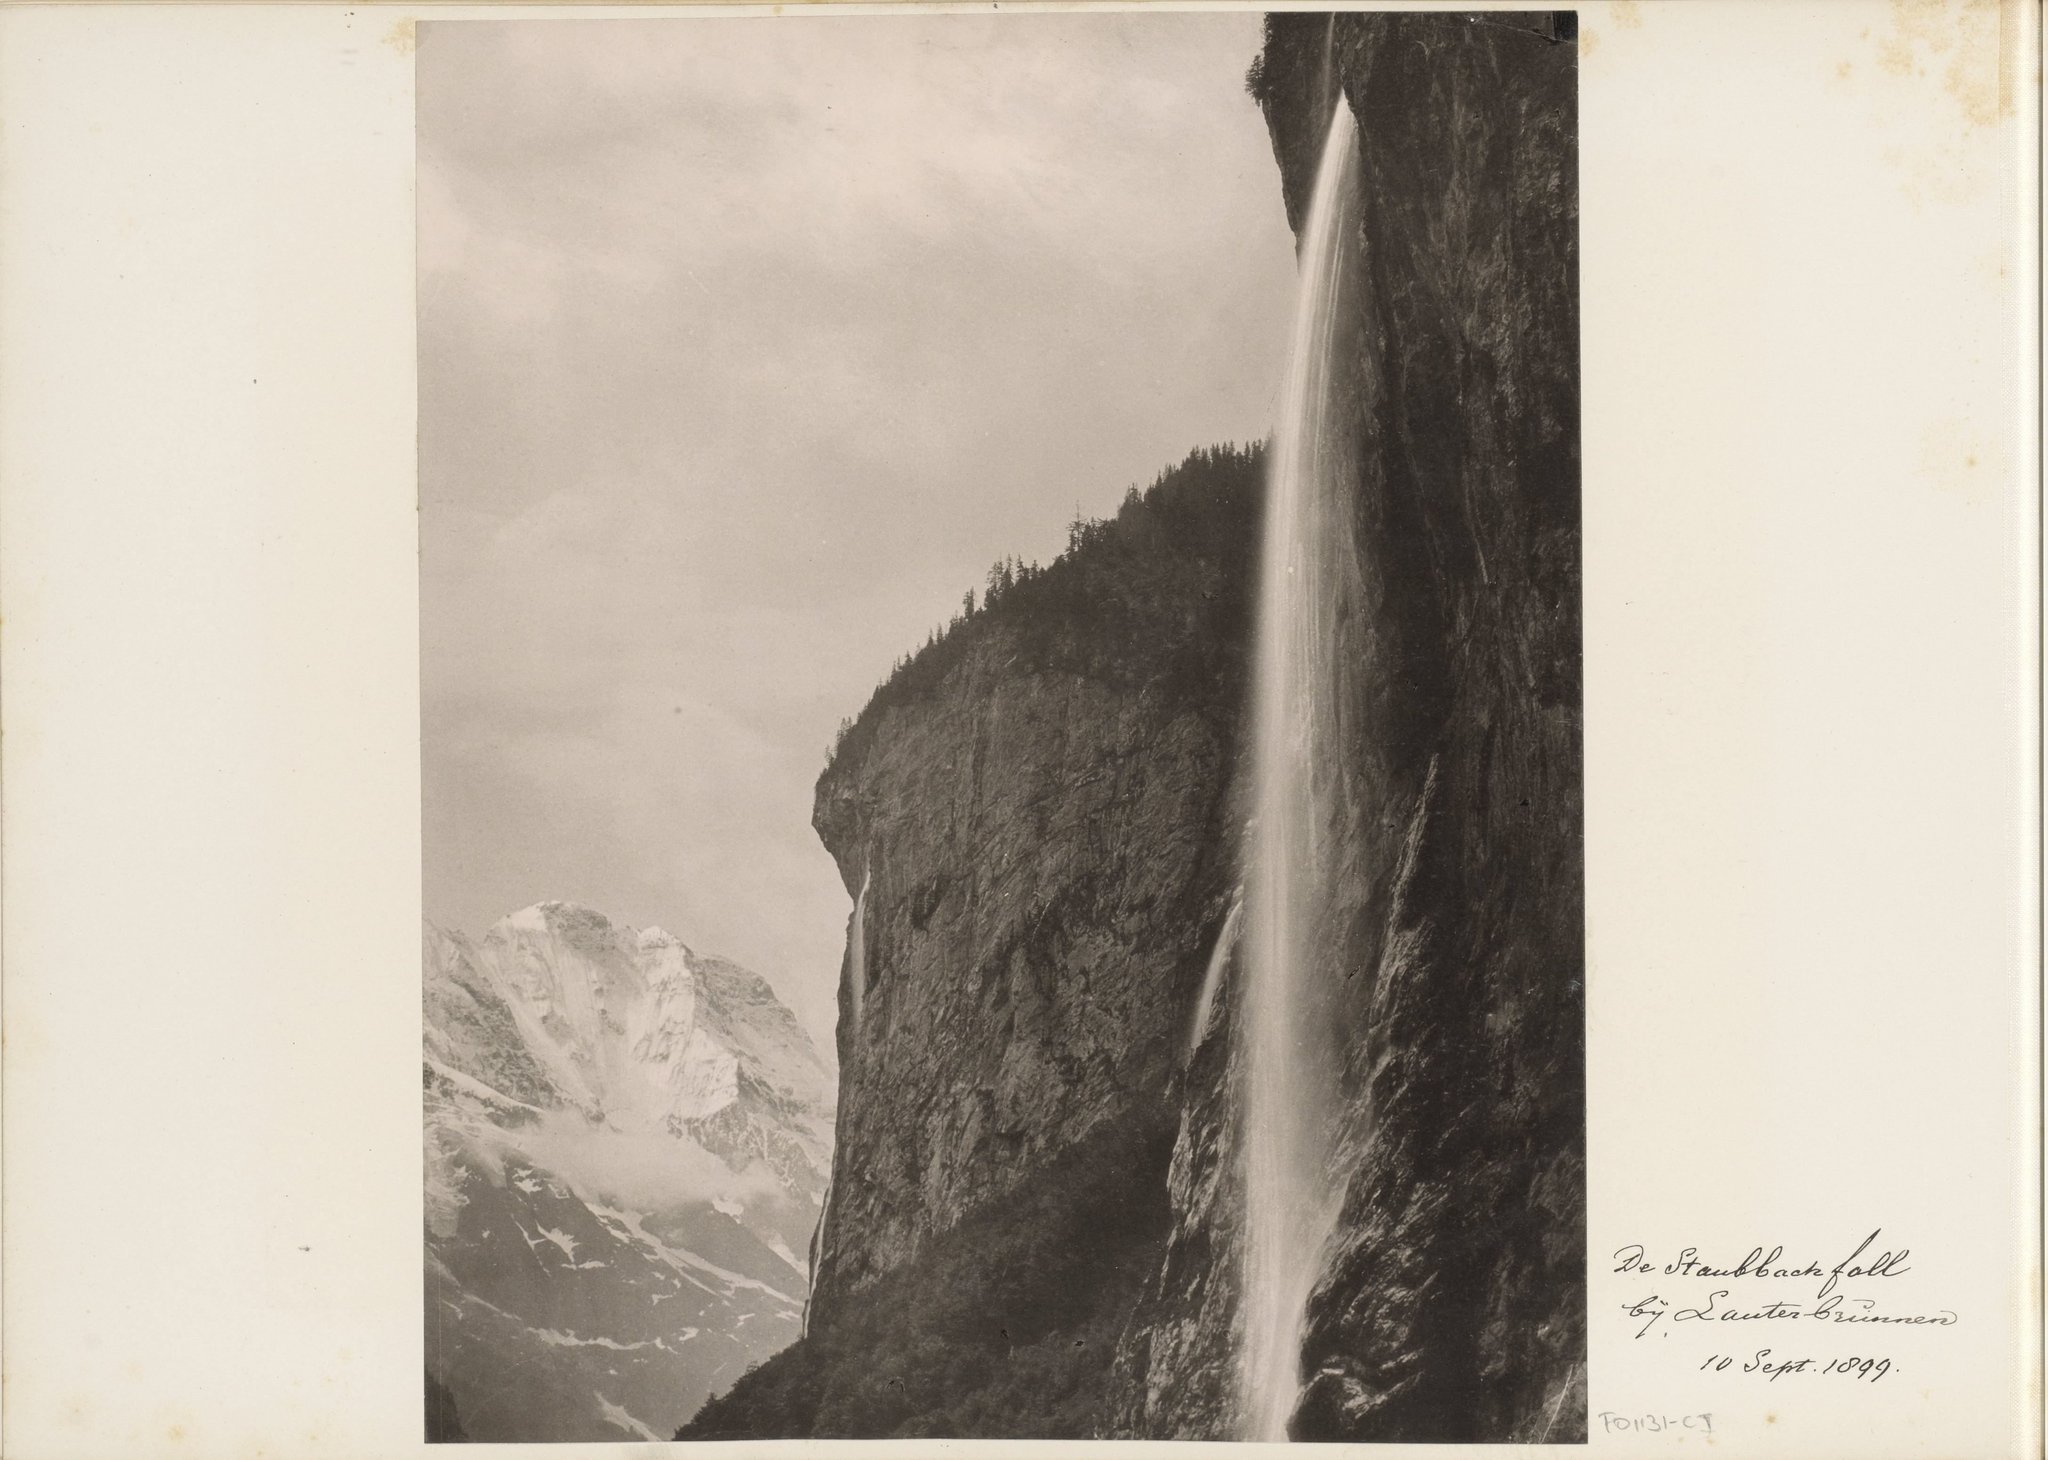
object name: album leaf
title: Staubbachwaterval bij Lauterbrunnen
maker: Anonymous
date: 1880-1899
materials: paper, photographic support, ink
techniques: photograph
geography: lauterbrunnen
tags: waterfall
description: Onderdeel van Reisalbum met bezienswaardigheden in Duitsland, Oostenrijk, Zwitserland, Luxemburg en België.